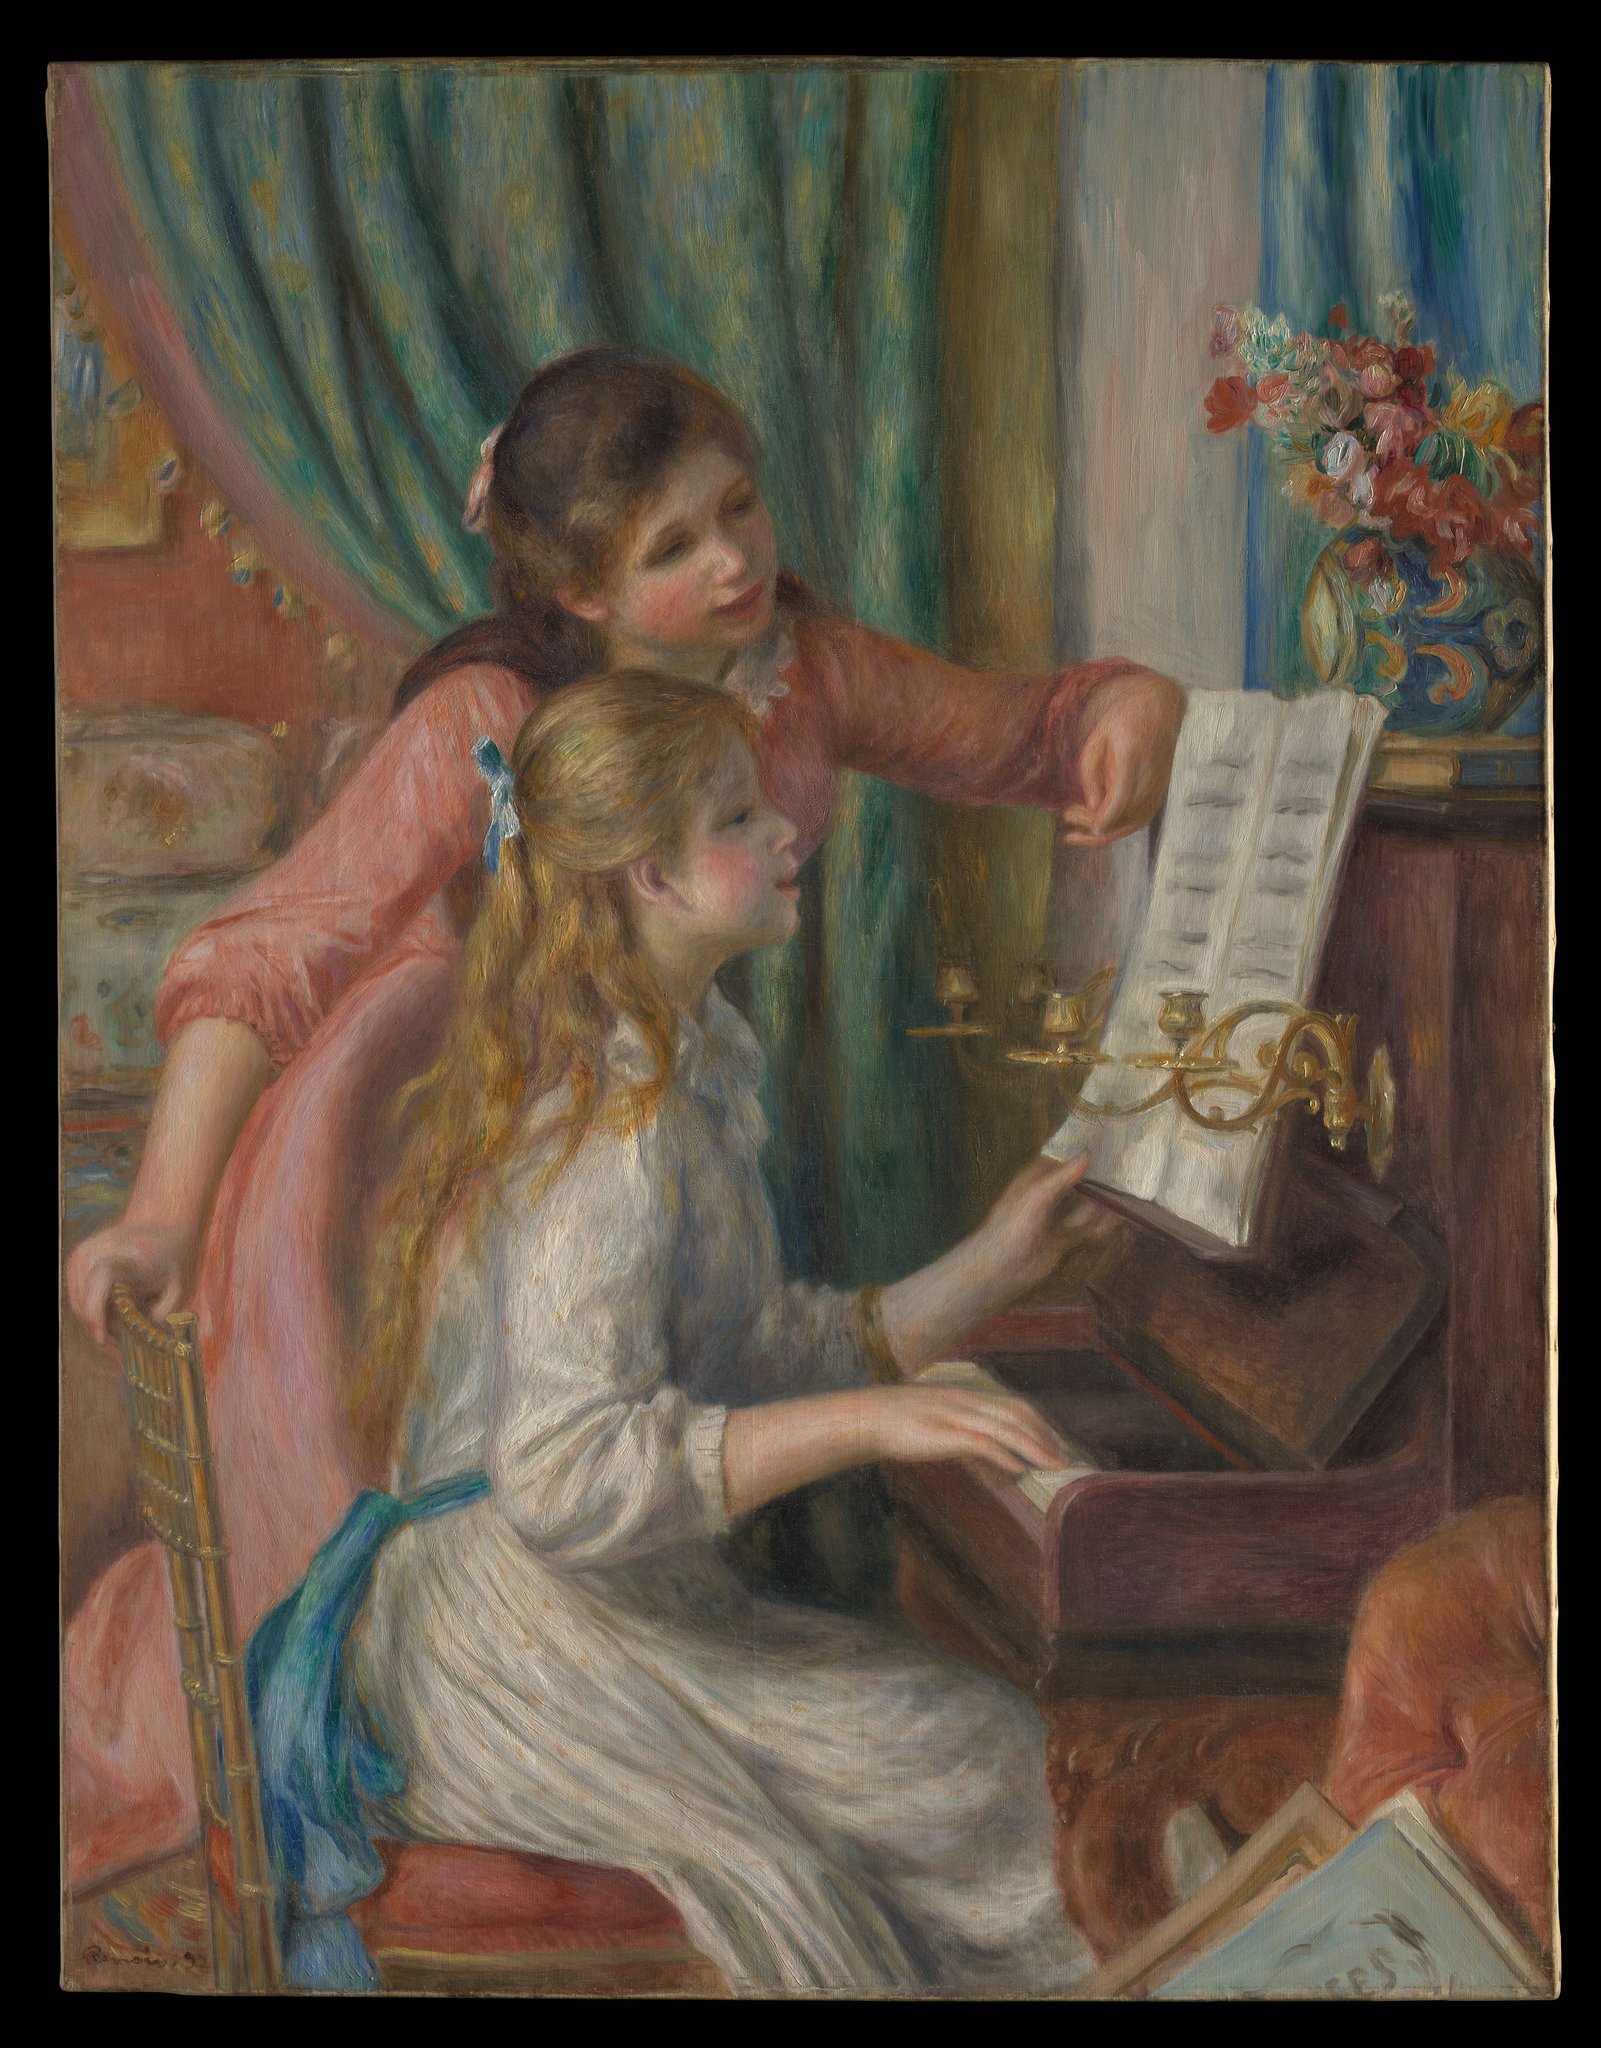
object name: painting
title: Two Young Girls at the Piano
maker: pierre auguste renoir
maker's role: artist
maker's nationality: french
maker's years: 1841-1919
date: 1892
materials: canvas, oil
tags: girls,music,pianos